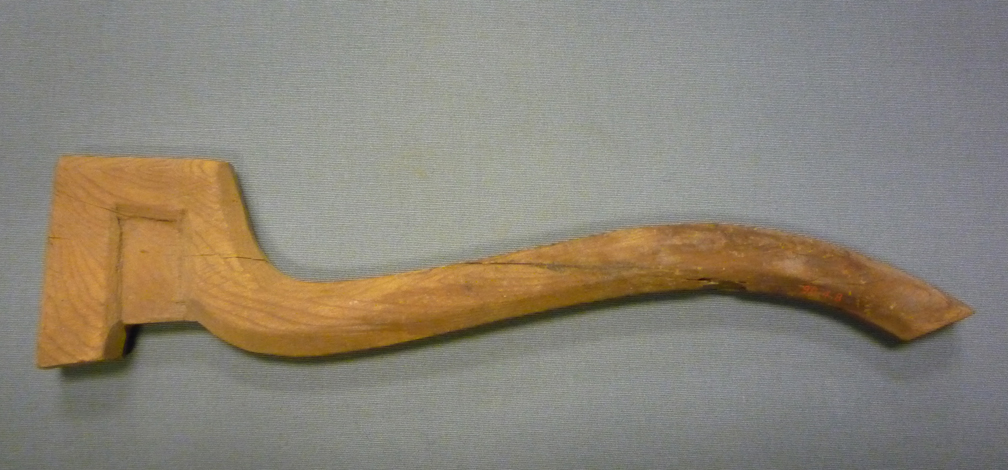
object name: adze, meskhetyu, hatshepsut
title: Mesekhtyu Instrument from a Foundation Deposit for Hatshepsut's Temple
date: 1479-1458 BCE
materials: wood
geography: egypt